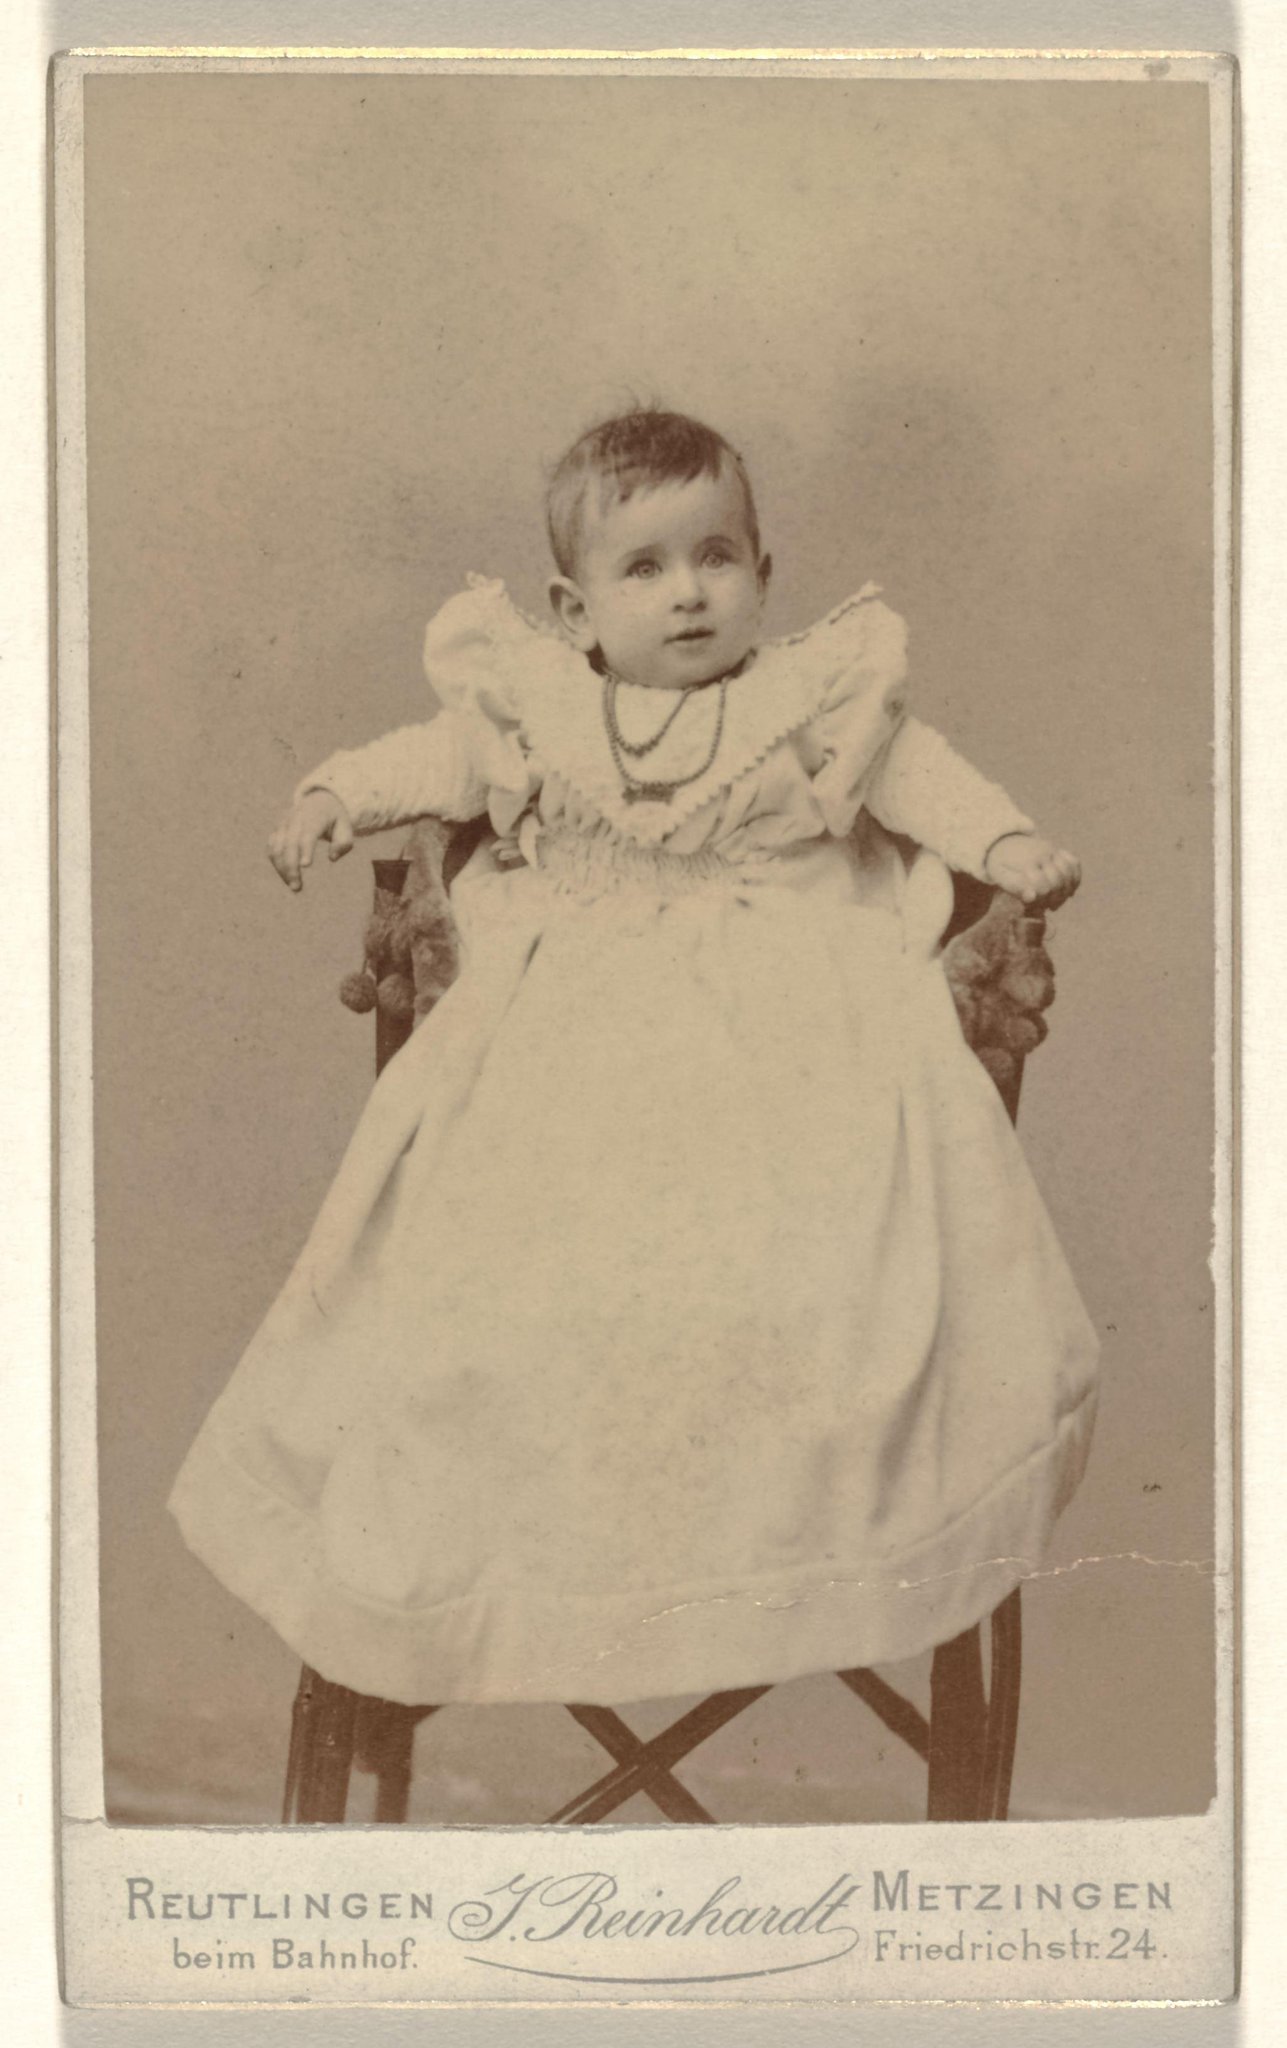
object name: photograph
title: Jong kind, vermoedelijk Else Wachenheimer-Moos, in kinderjurk met kort haar en met een ketting om haar nek, in een kinderstoel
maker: j. reinhardt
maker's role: fotograaf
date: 1870-1900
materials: photographic support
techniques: gelatin silver print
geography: reutlingen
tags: else wachenheimer-moos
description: Jong kind in kinderjurk met kort haar en met een ketting om haar nek, in een kinderstoel.